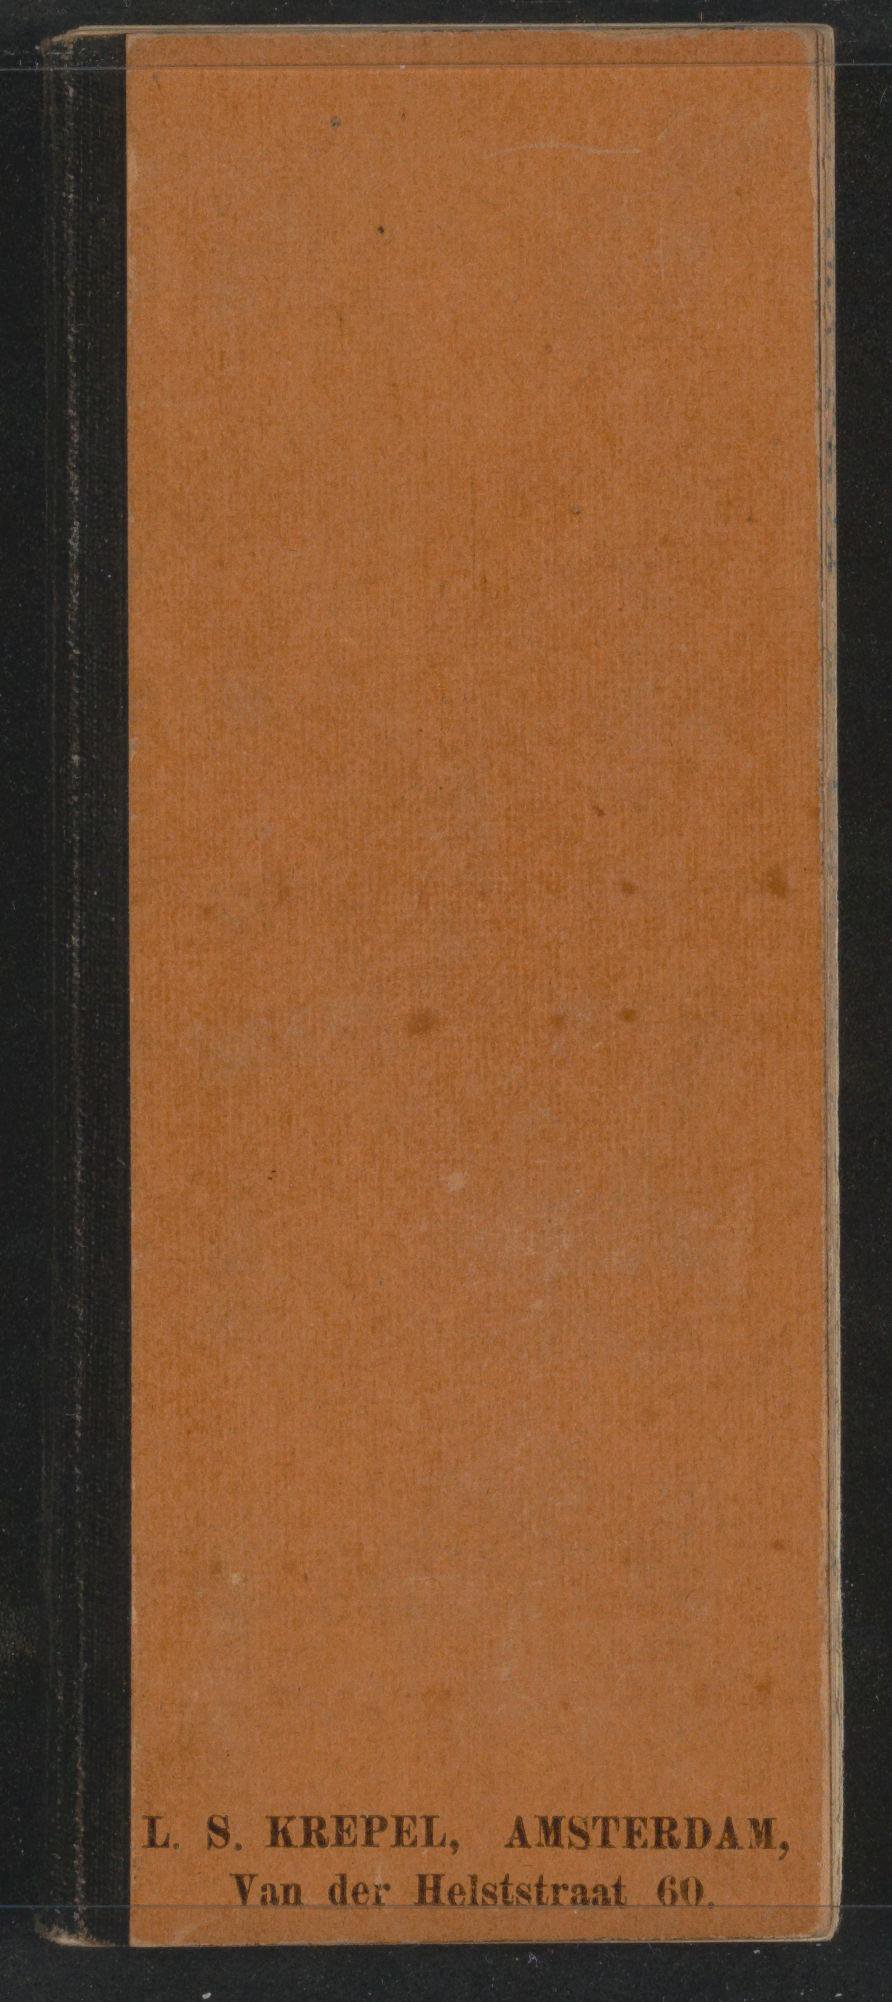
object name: sketchbook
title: Schetsboek met 40 bladen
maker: gerrit willem dijsselhof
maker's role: designer, draughtsman, print maker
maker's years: 1866-1924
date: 1876-1924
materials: cardboard, chalk, linen, paper, pencil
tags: ornaments ~ art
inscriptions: annotation: ‘van N. voor Rus/ 16.40’, retailer's mark: ‘L.S. KREPEL, AMSTERDAM,/ Van der Helststraat 60.’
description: De volgende bladen uit het schetsboek zijn blanco: 1(V) t/m 7(V), 8, 9(R) t/m 31(R) en 33(R) t/m 40(R).